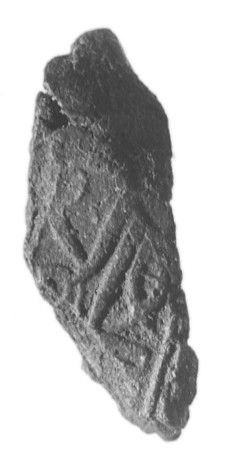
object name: sealing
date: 2030-1640 BCE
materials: clay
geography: egypt